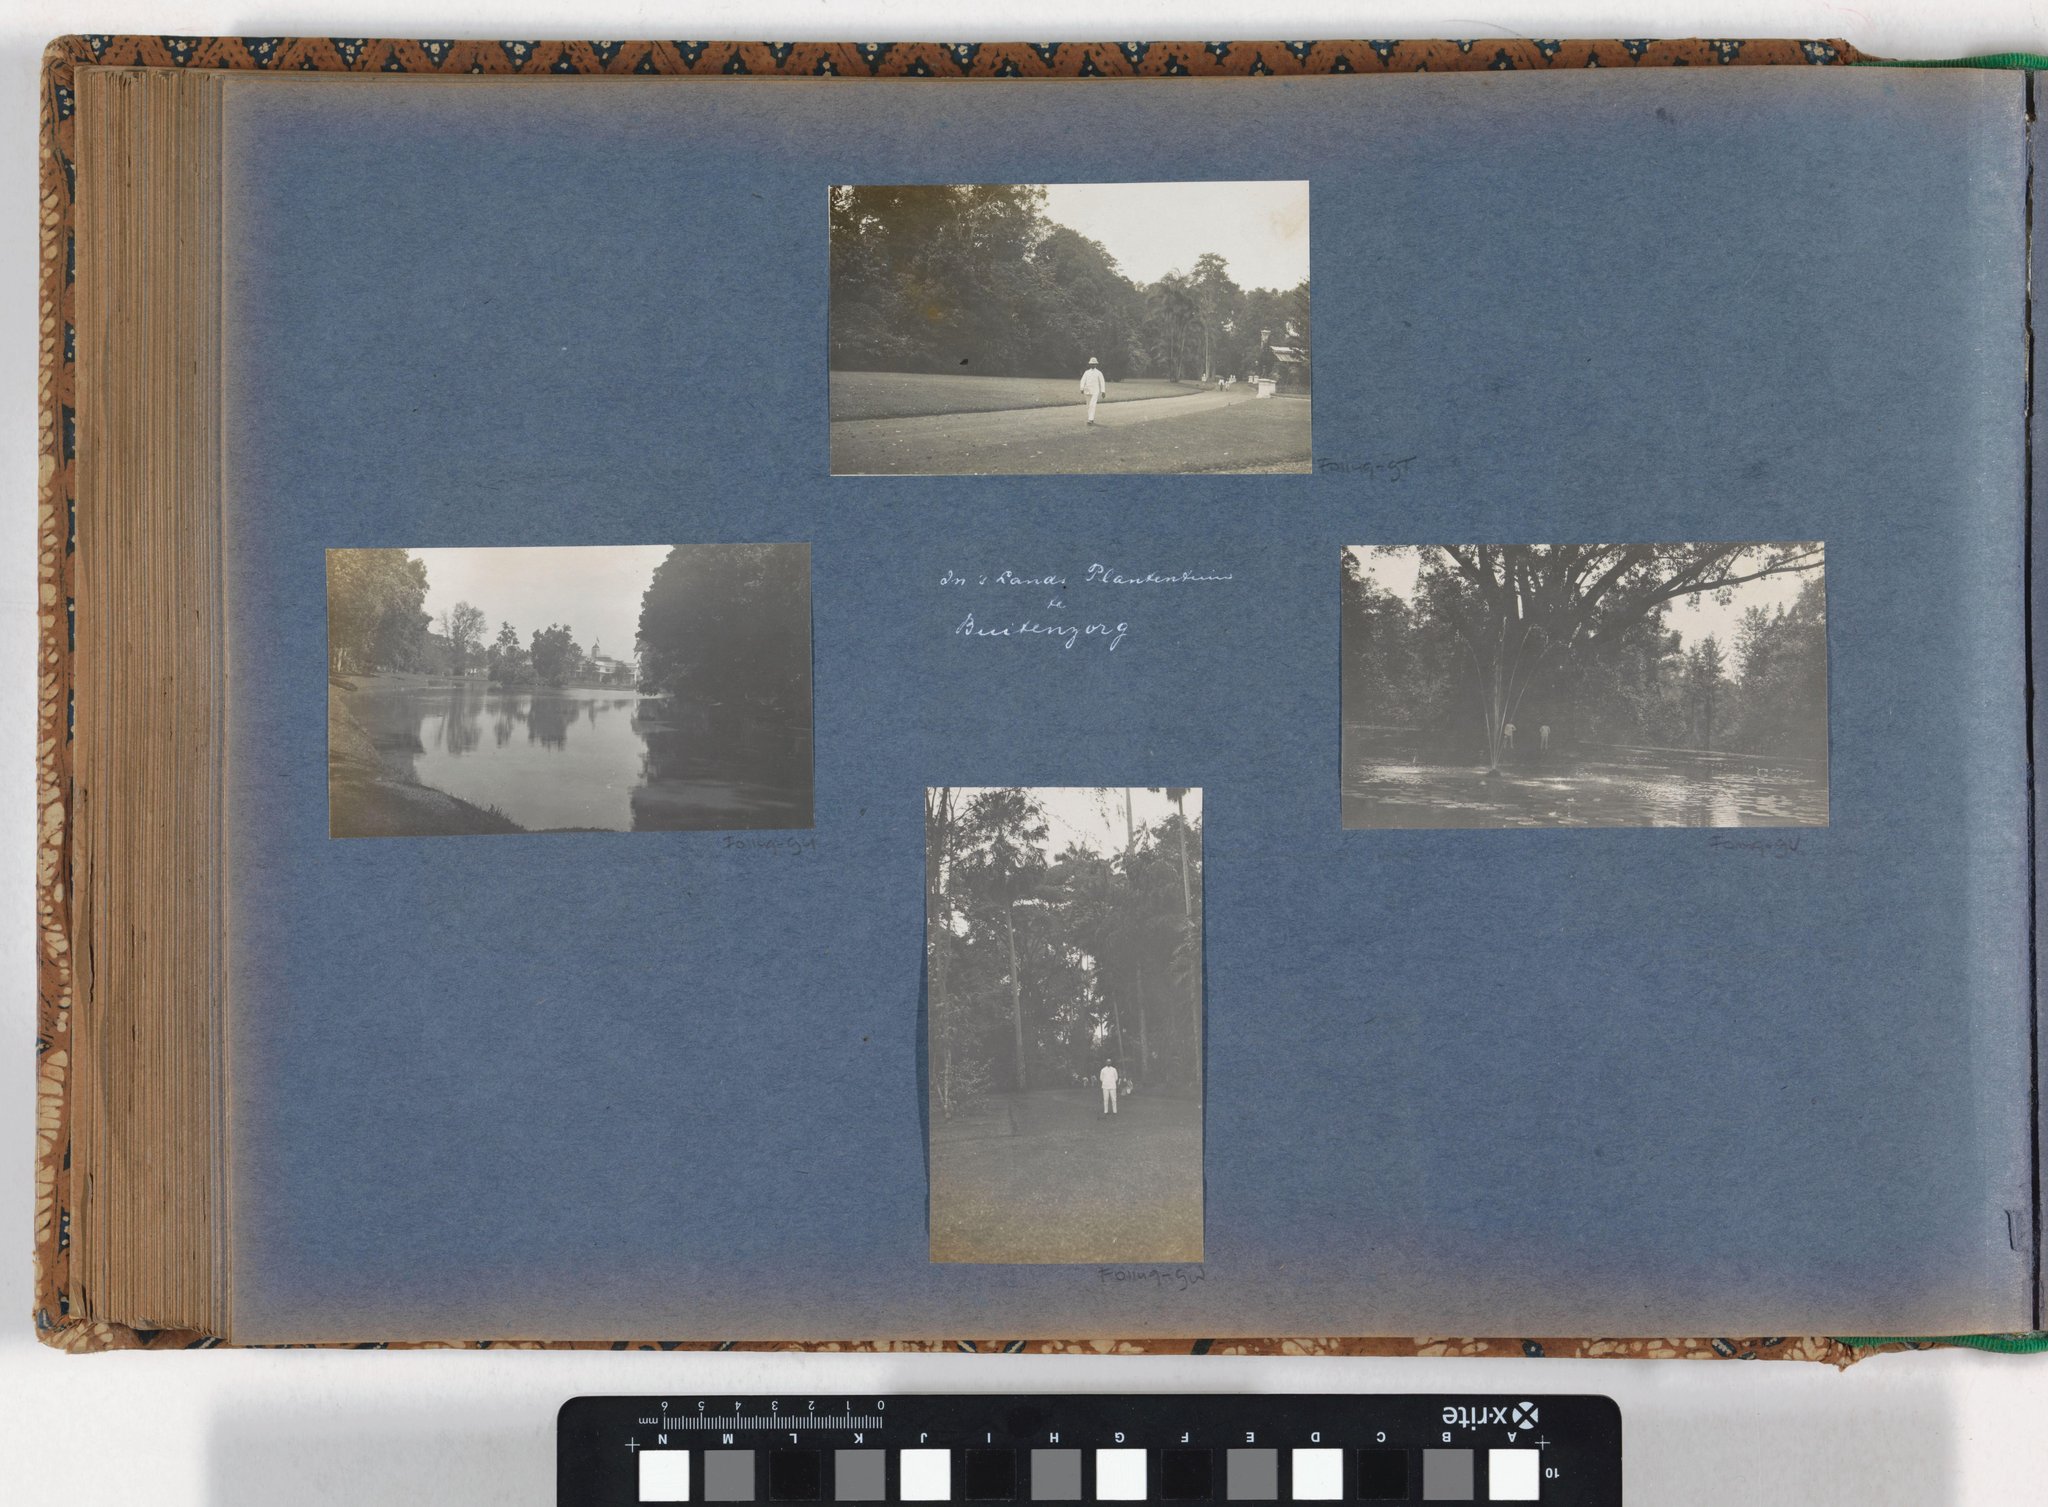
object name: album leaf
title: Europeaan poserend in een laan in 's Lands Plantentuin te Buitenzorg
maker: Anonymous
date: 1900-1920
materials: paper, photographic support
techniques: gelatin silver print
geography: s lands plantentuin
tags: forest path or lane, botanic garden, 'hortus botanicus'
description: Onderdeel van reisalbum met foto's van bedrijvigheid en bezienswaardigheden op Sumatra en Java en van de reis naar en van Nederlands-Indië.